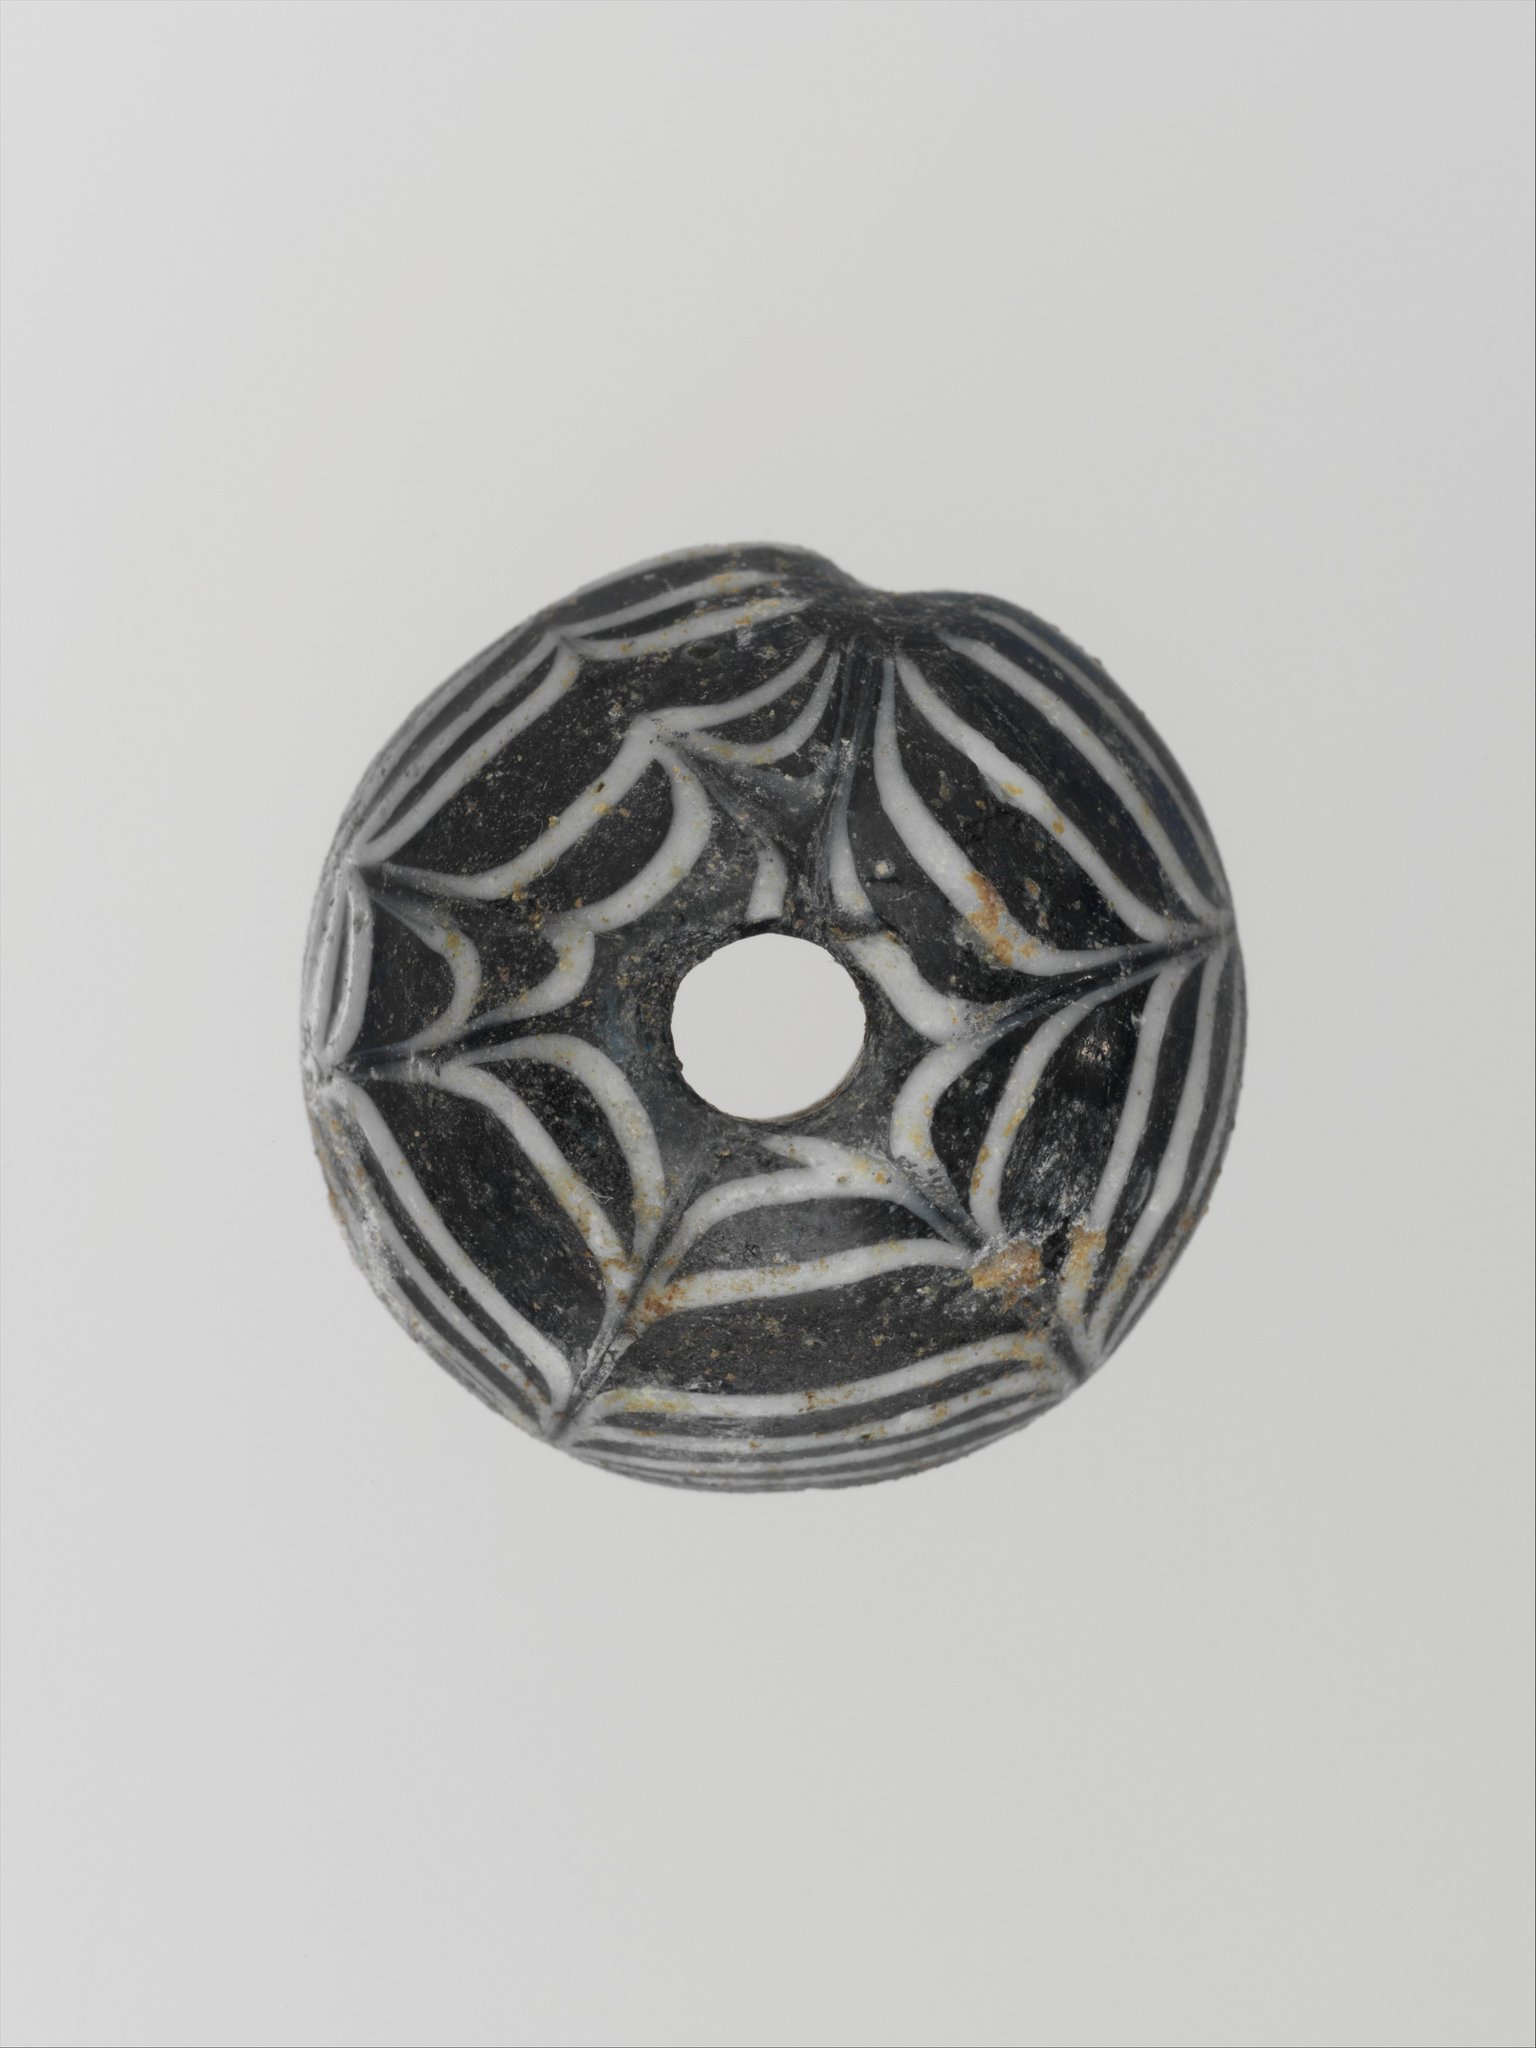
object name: spindle whorl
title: Glass spindle whorl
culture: roman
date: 1-200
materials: glass